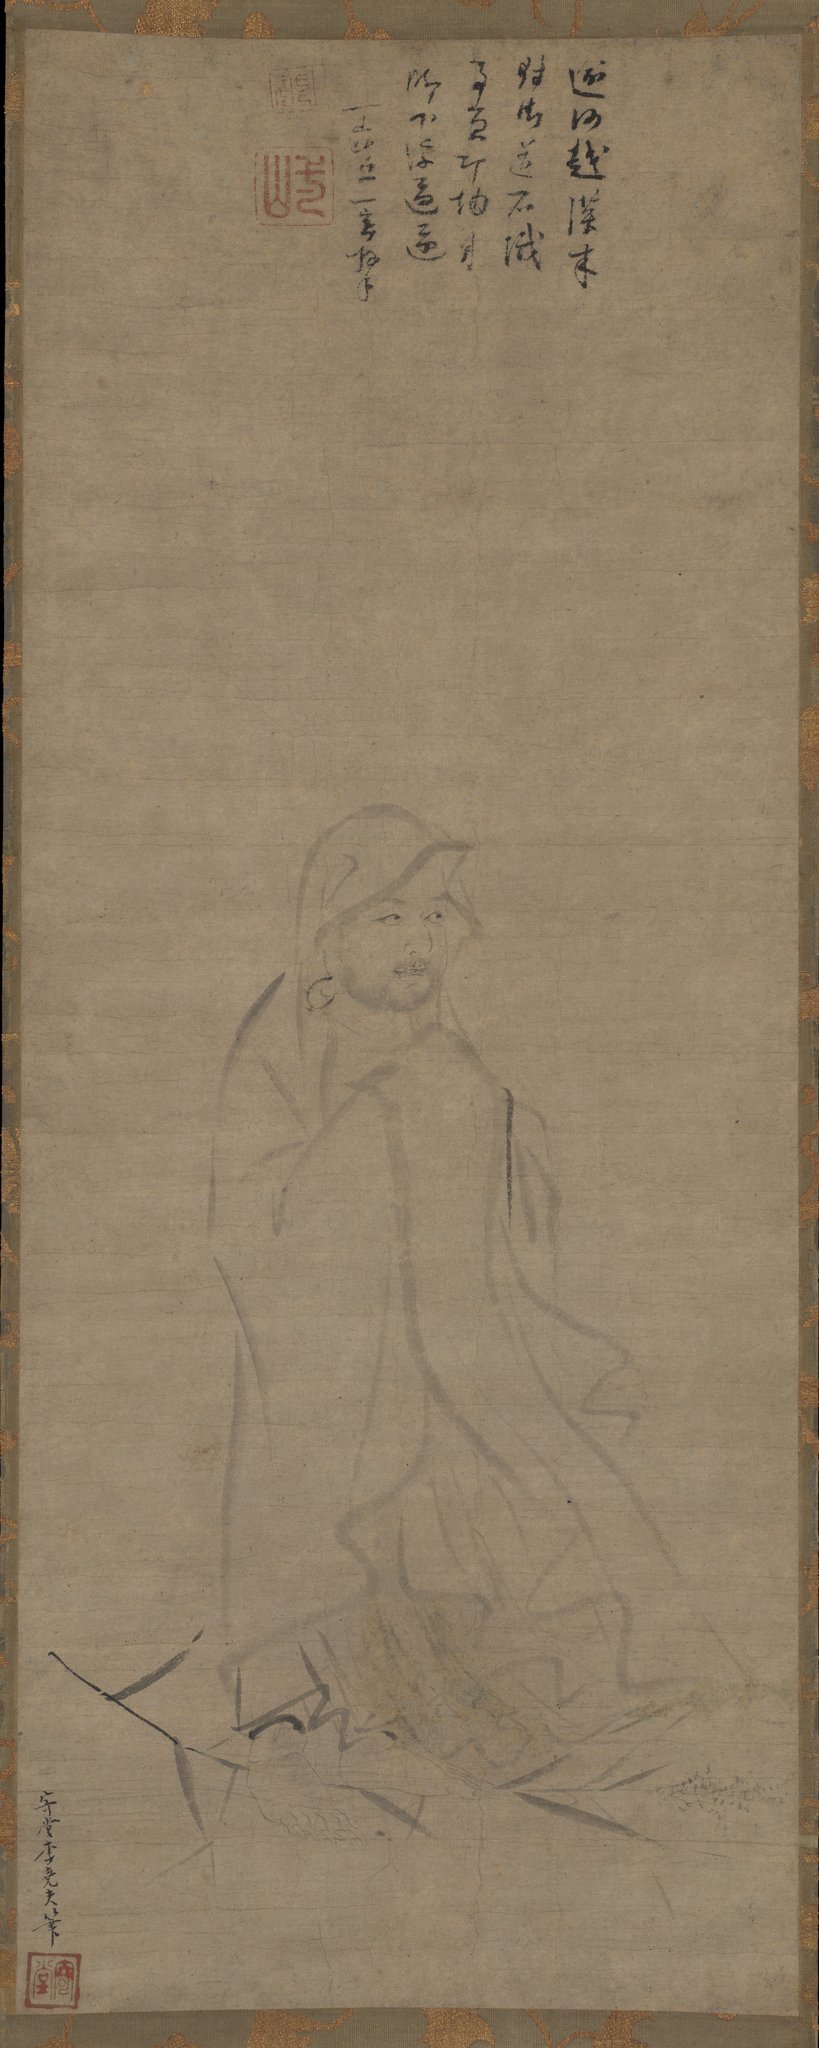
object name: hanging scroll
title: Bodhidharma crossing the Yangzi River on a reed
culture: chinese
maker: li yaofu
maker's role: artist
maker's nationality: chinese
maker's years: 1300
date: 1317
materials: ink, paper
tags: men,buddhism